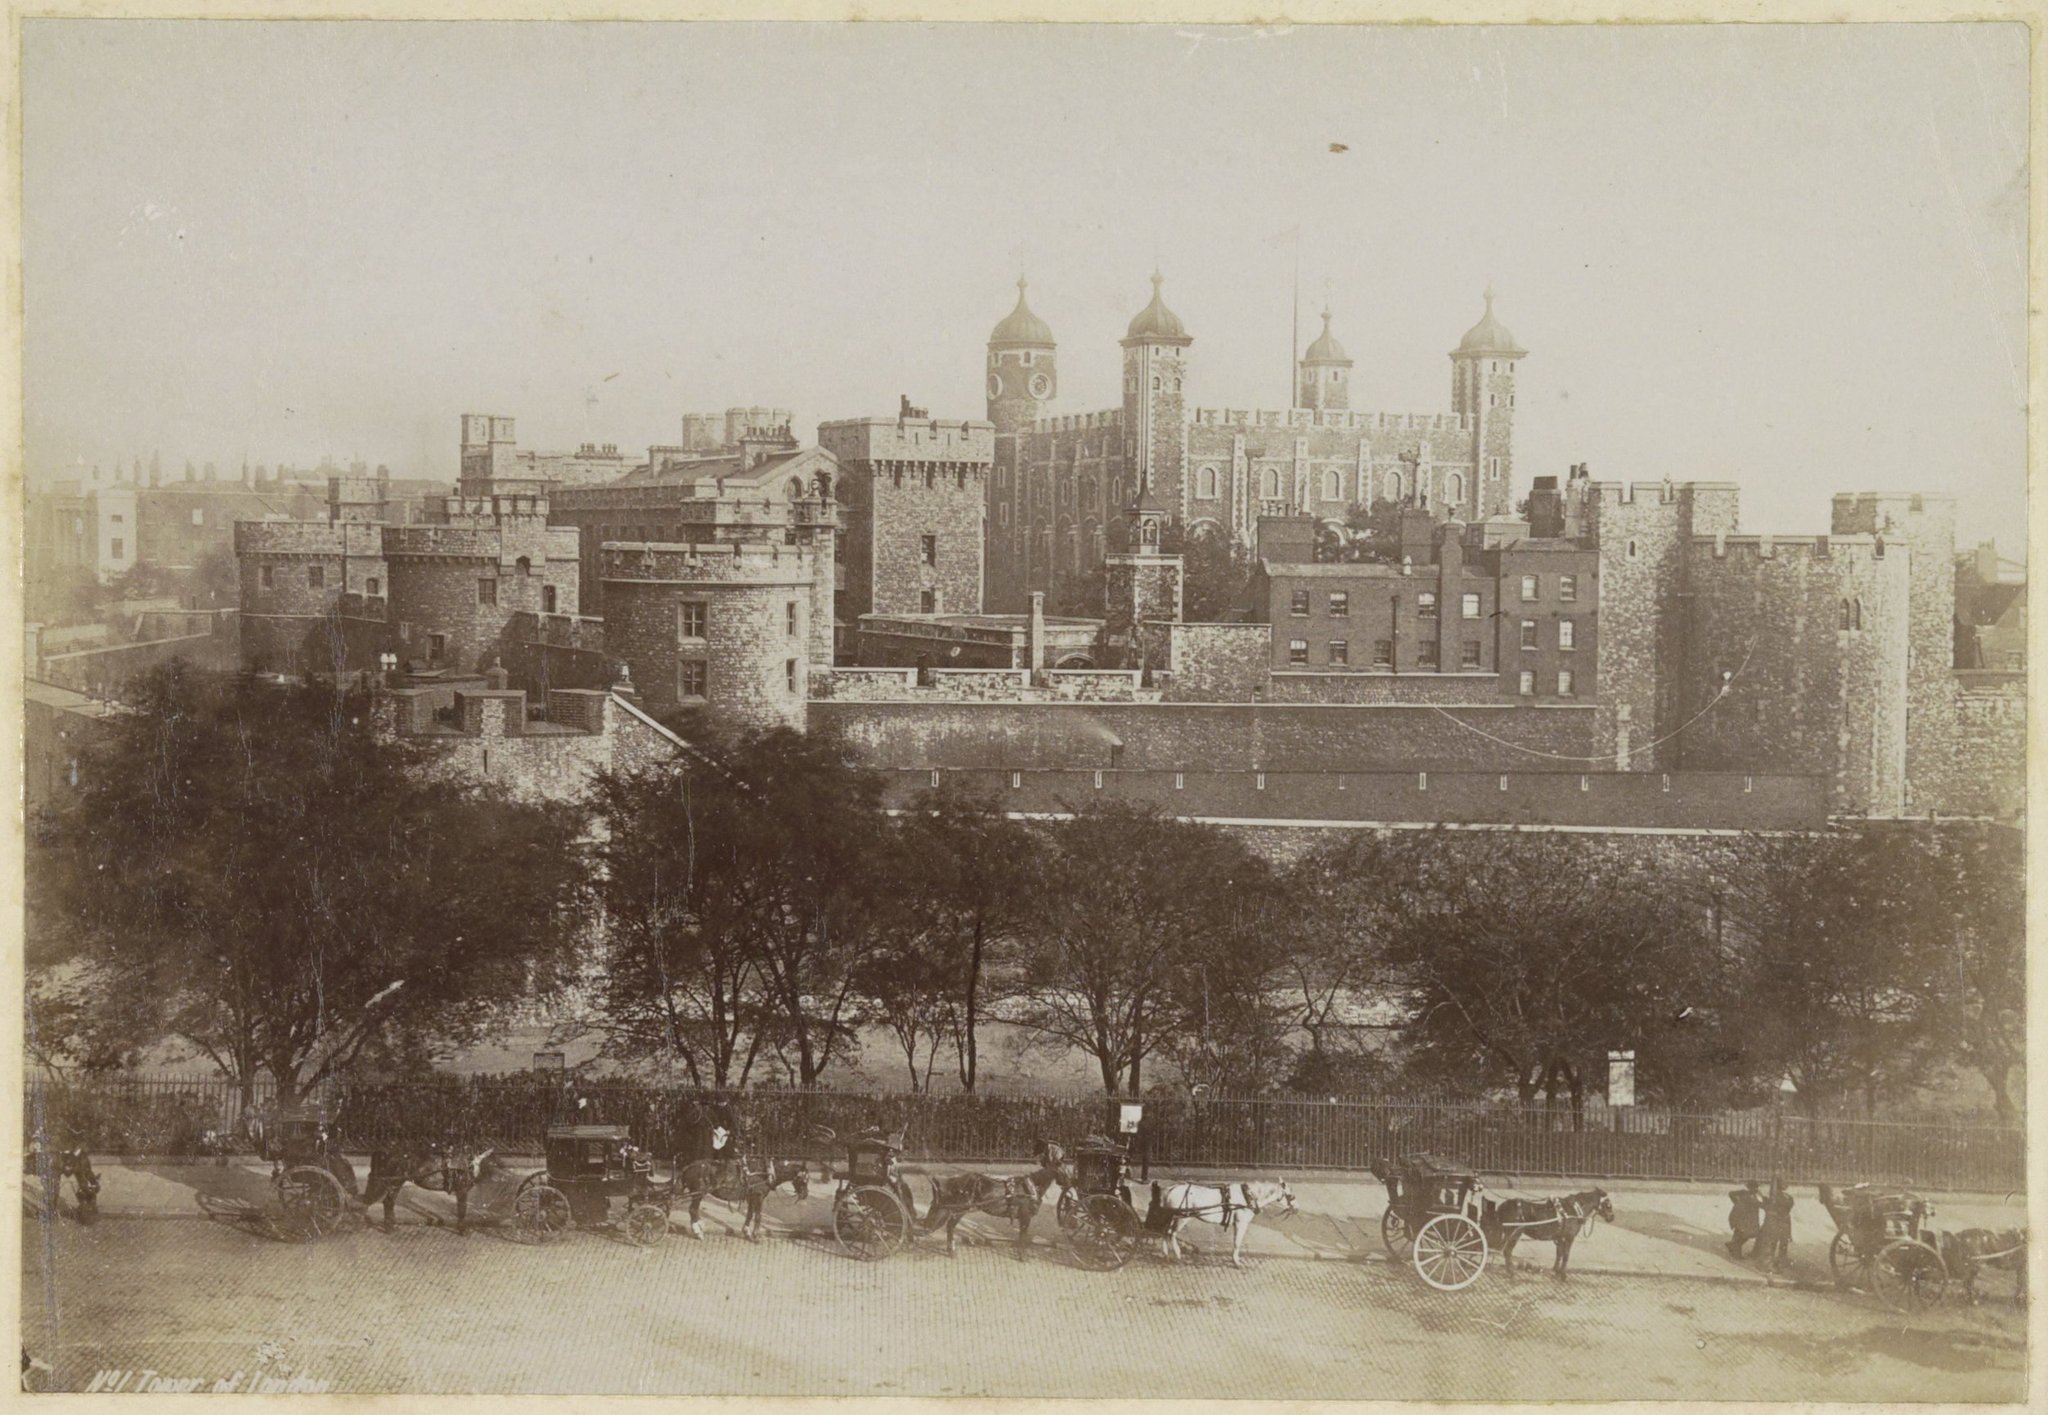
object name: photograph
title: Tower of London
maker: Anonymous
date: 1870-1890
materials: cardboard, photographic support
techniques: albumen print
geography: london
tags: animal traction, animal-drawn vehicle (carriage etc.), castle, prospect of city, town panorama, silhouette of city, london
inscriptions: number: ‘1’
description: Onderdeel van Fotoalbum met bezienswaardigheden in Edinburgh en Londen.